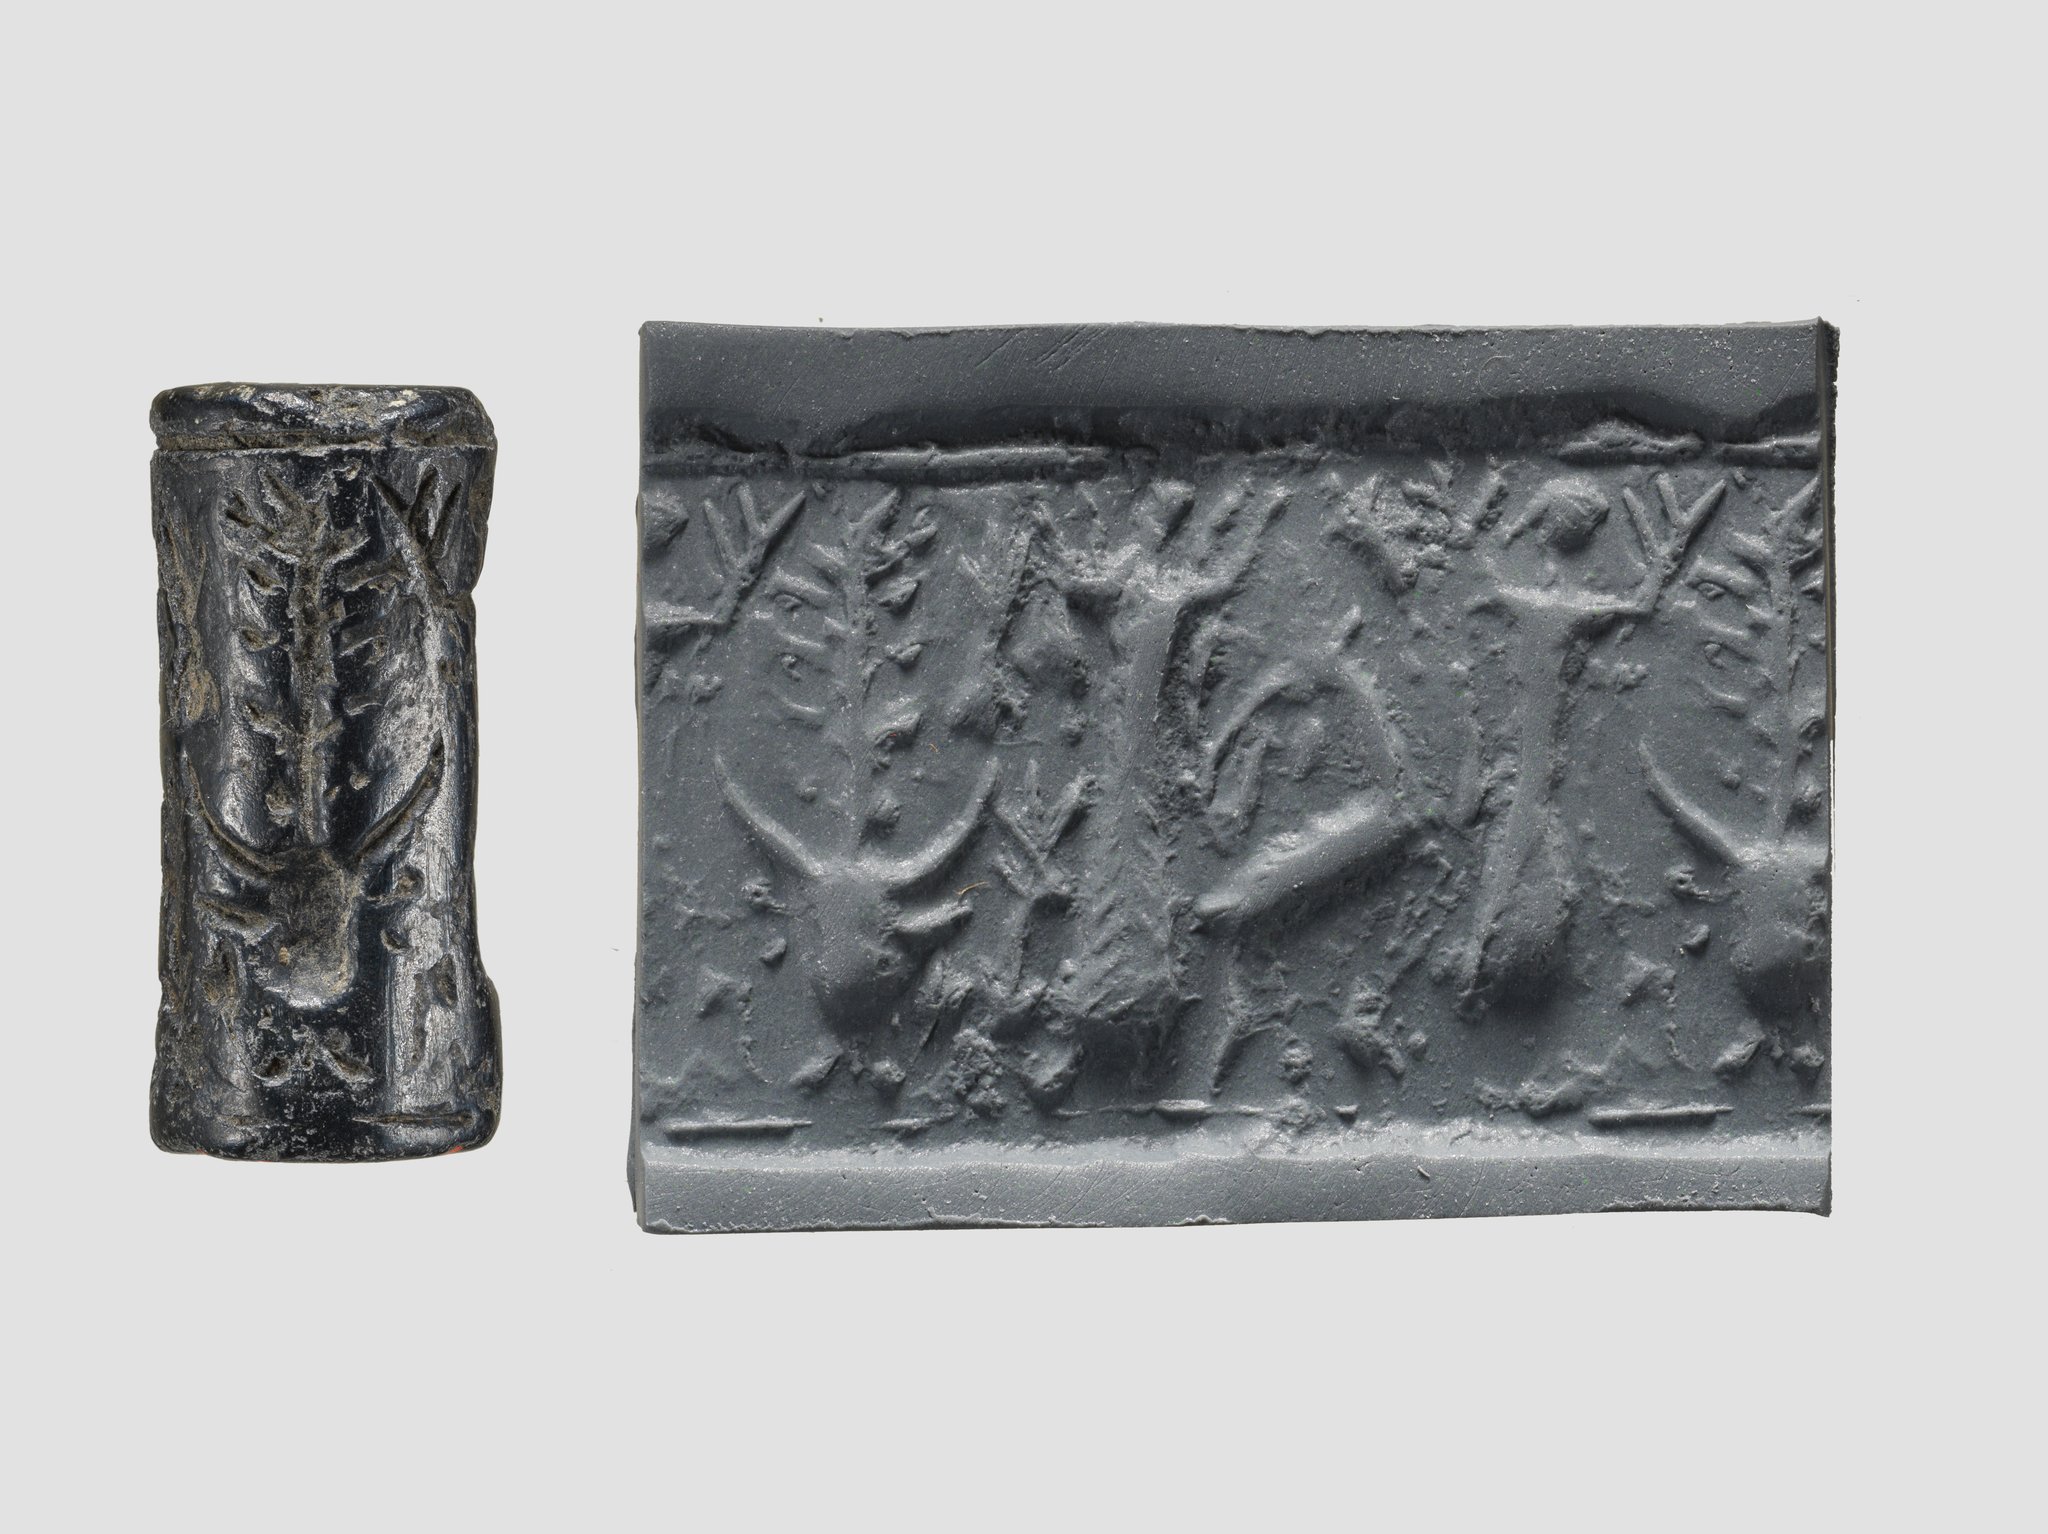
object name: cylinder seal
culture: cypriot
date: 1500-1201 BCE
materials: mineral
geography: cyprus